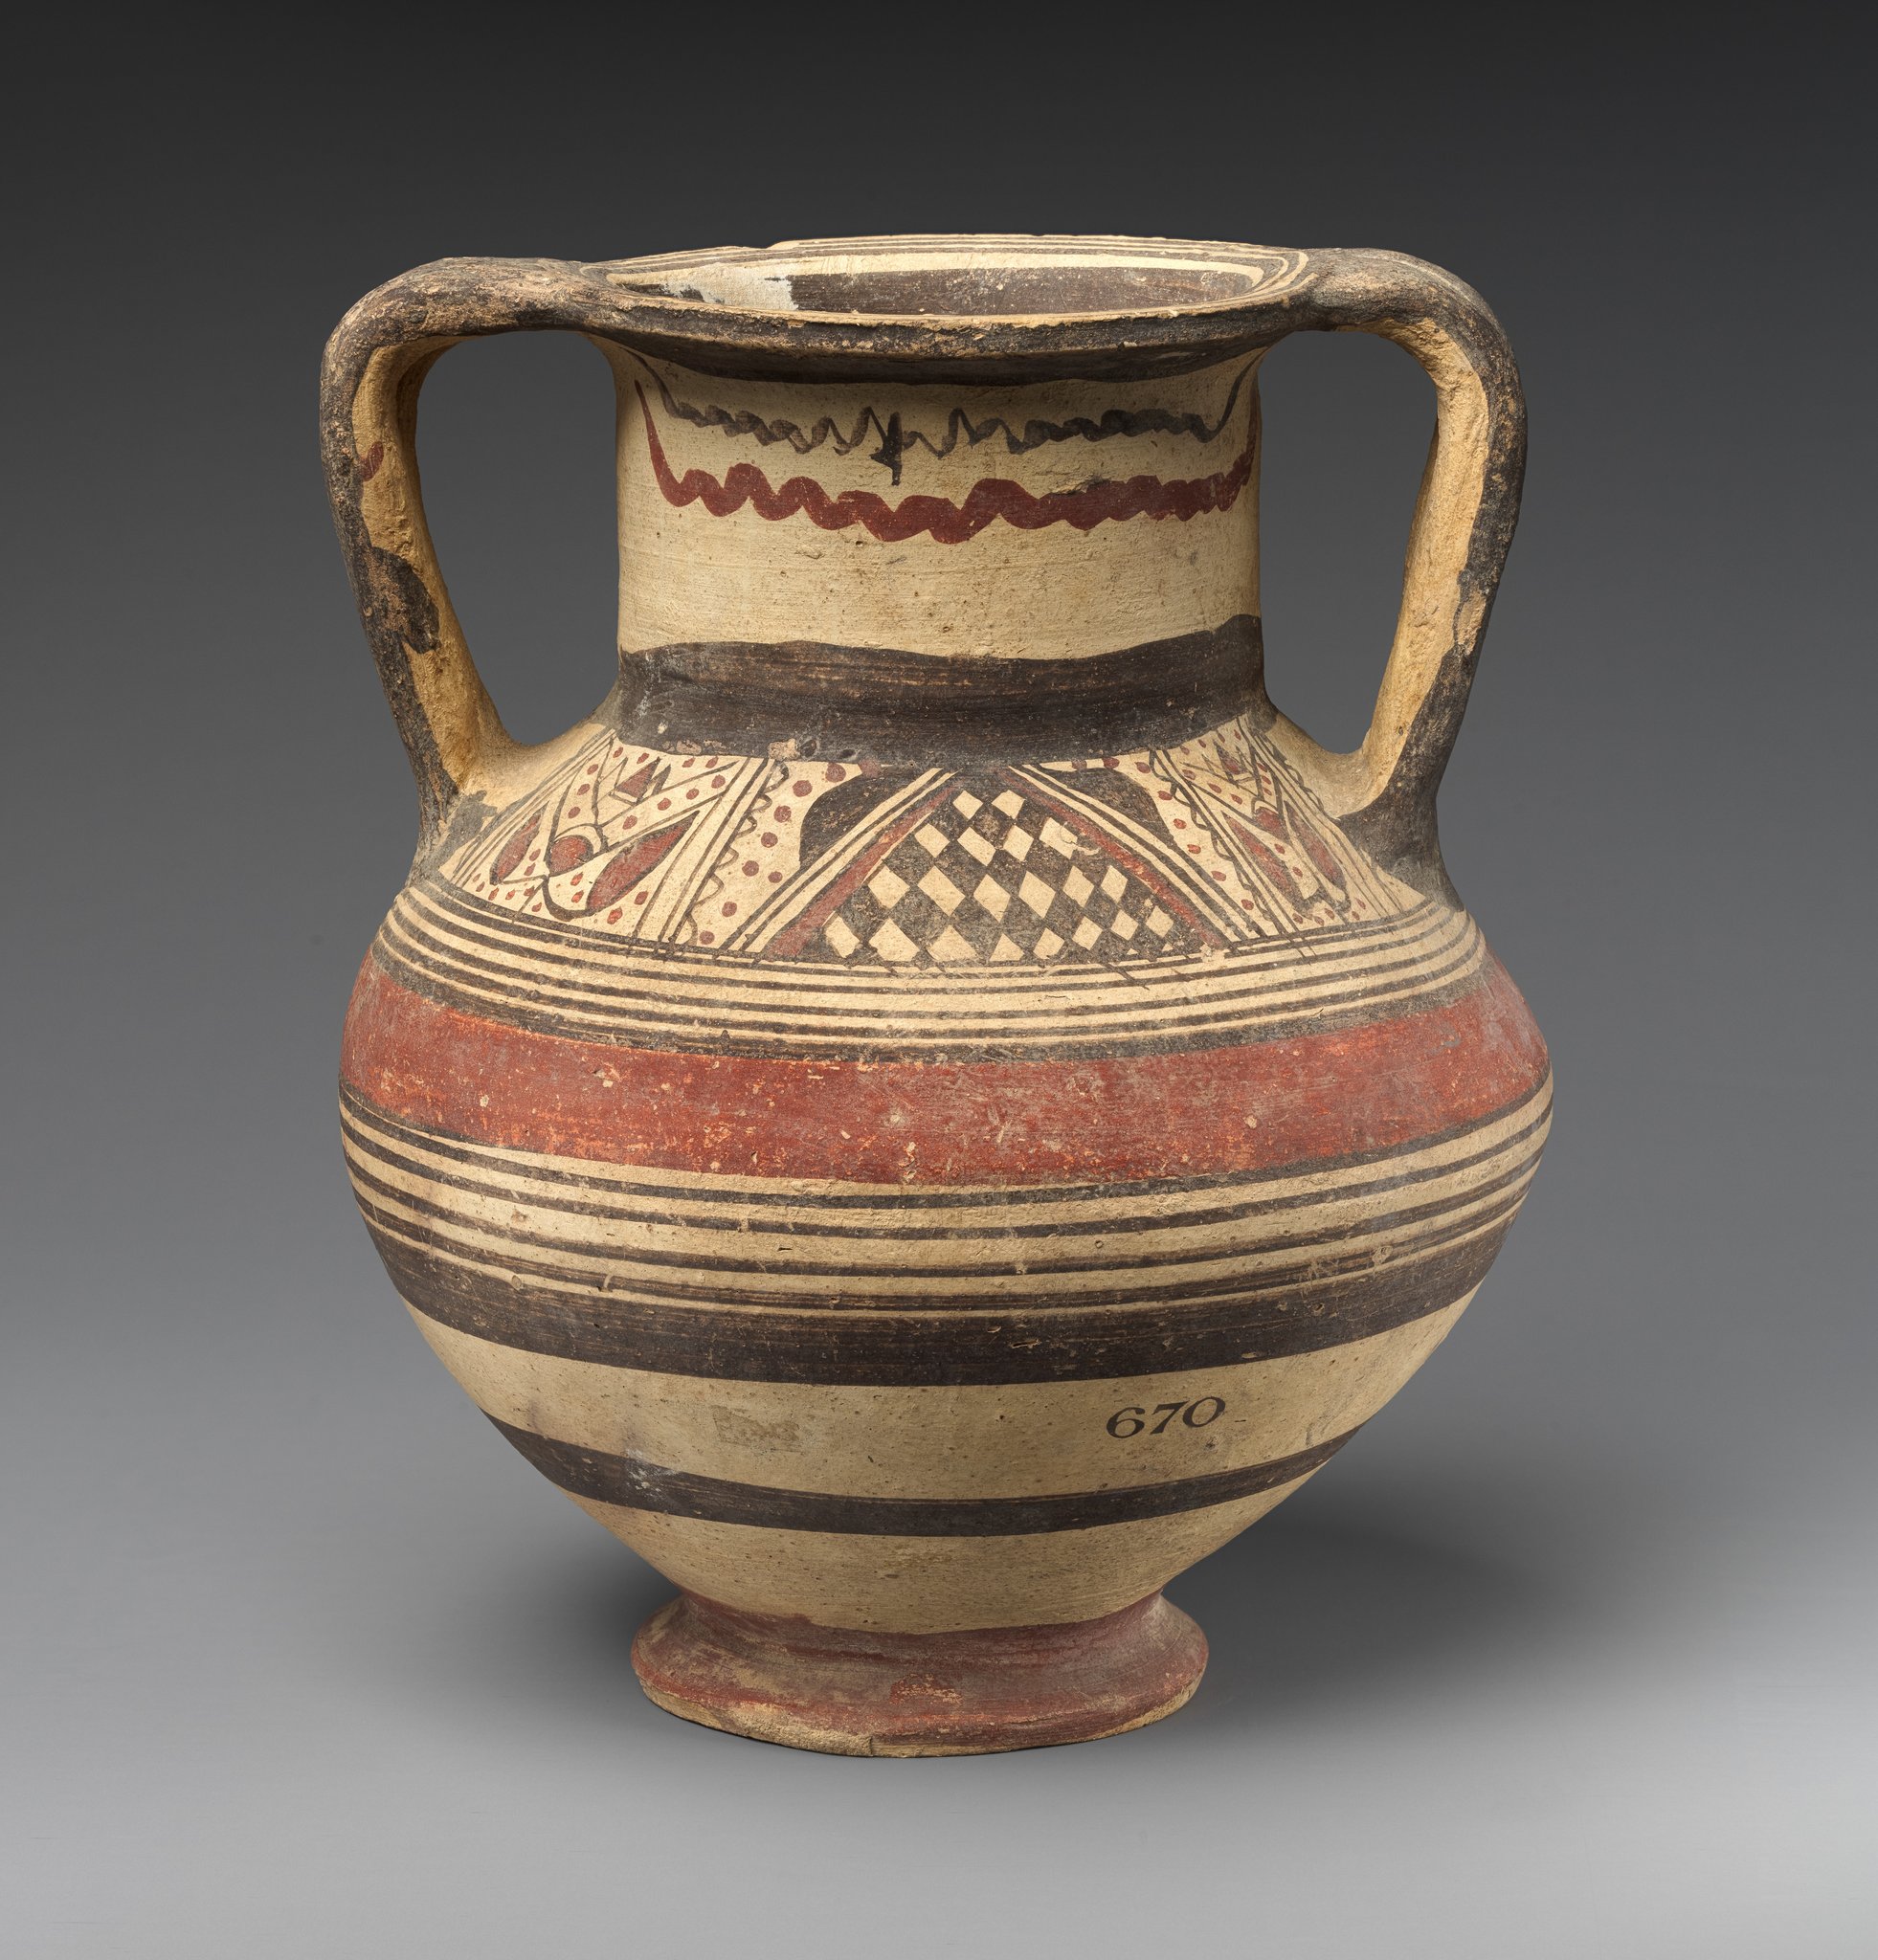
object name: krater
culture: cypriot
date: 750-600 BCE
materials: terracotta